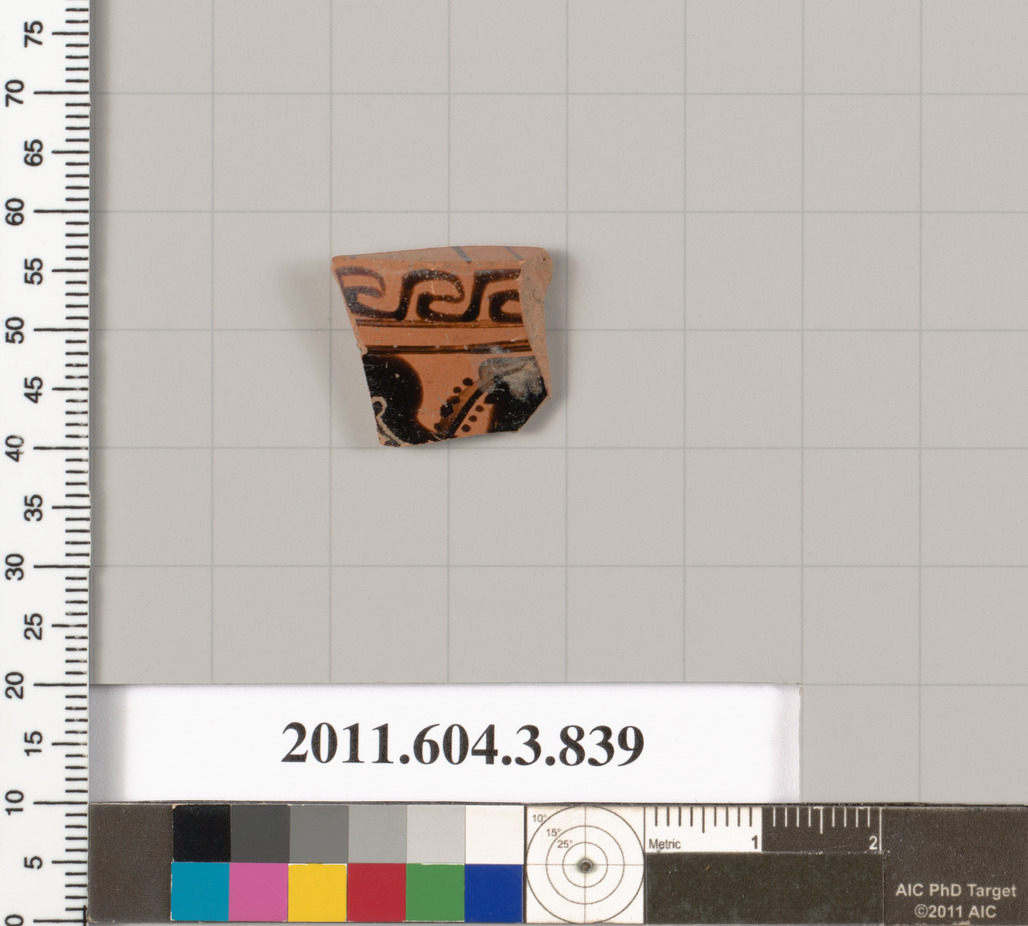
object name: lekythos fragment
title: Terracotta fragment of a lekythos (oil flask)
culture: greek, attic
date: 534-501 BCE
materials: terracotta